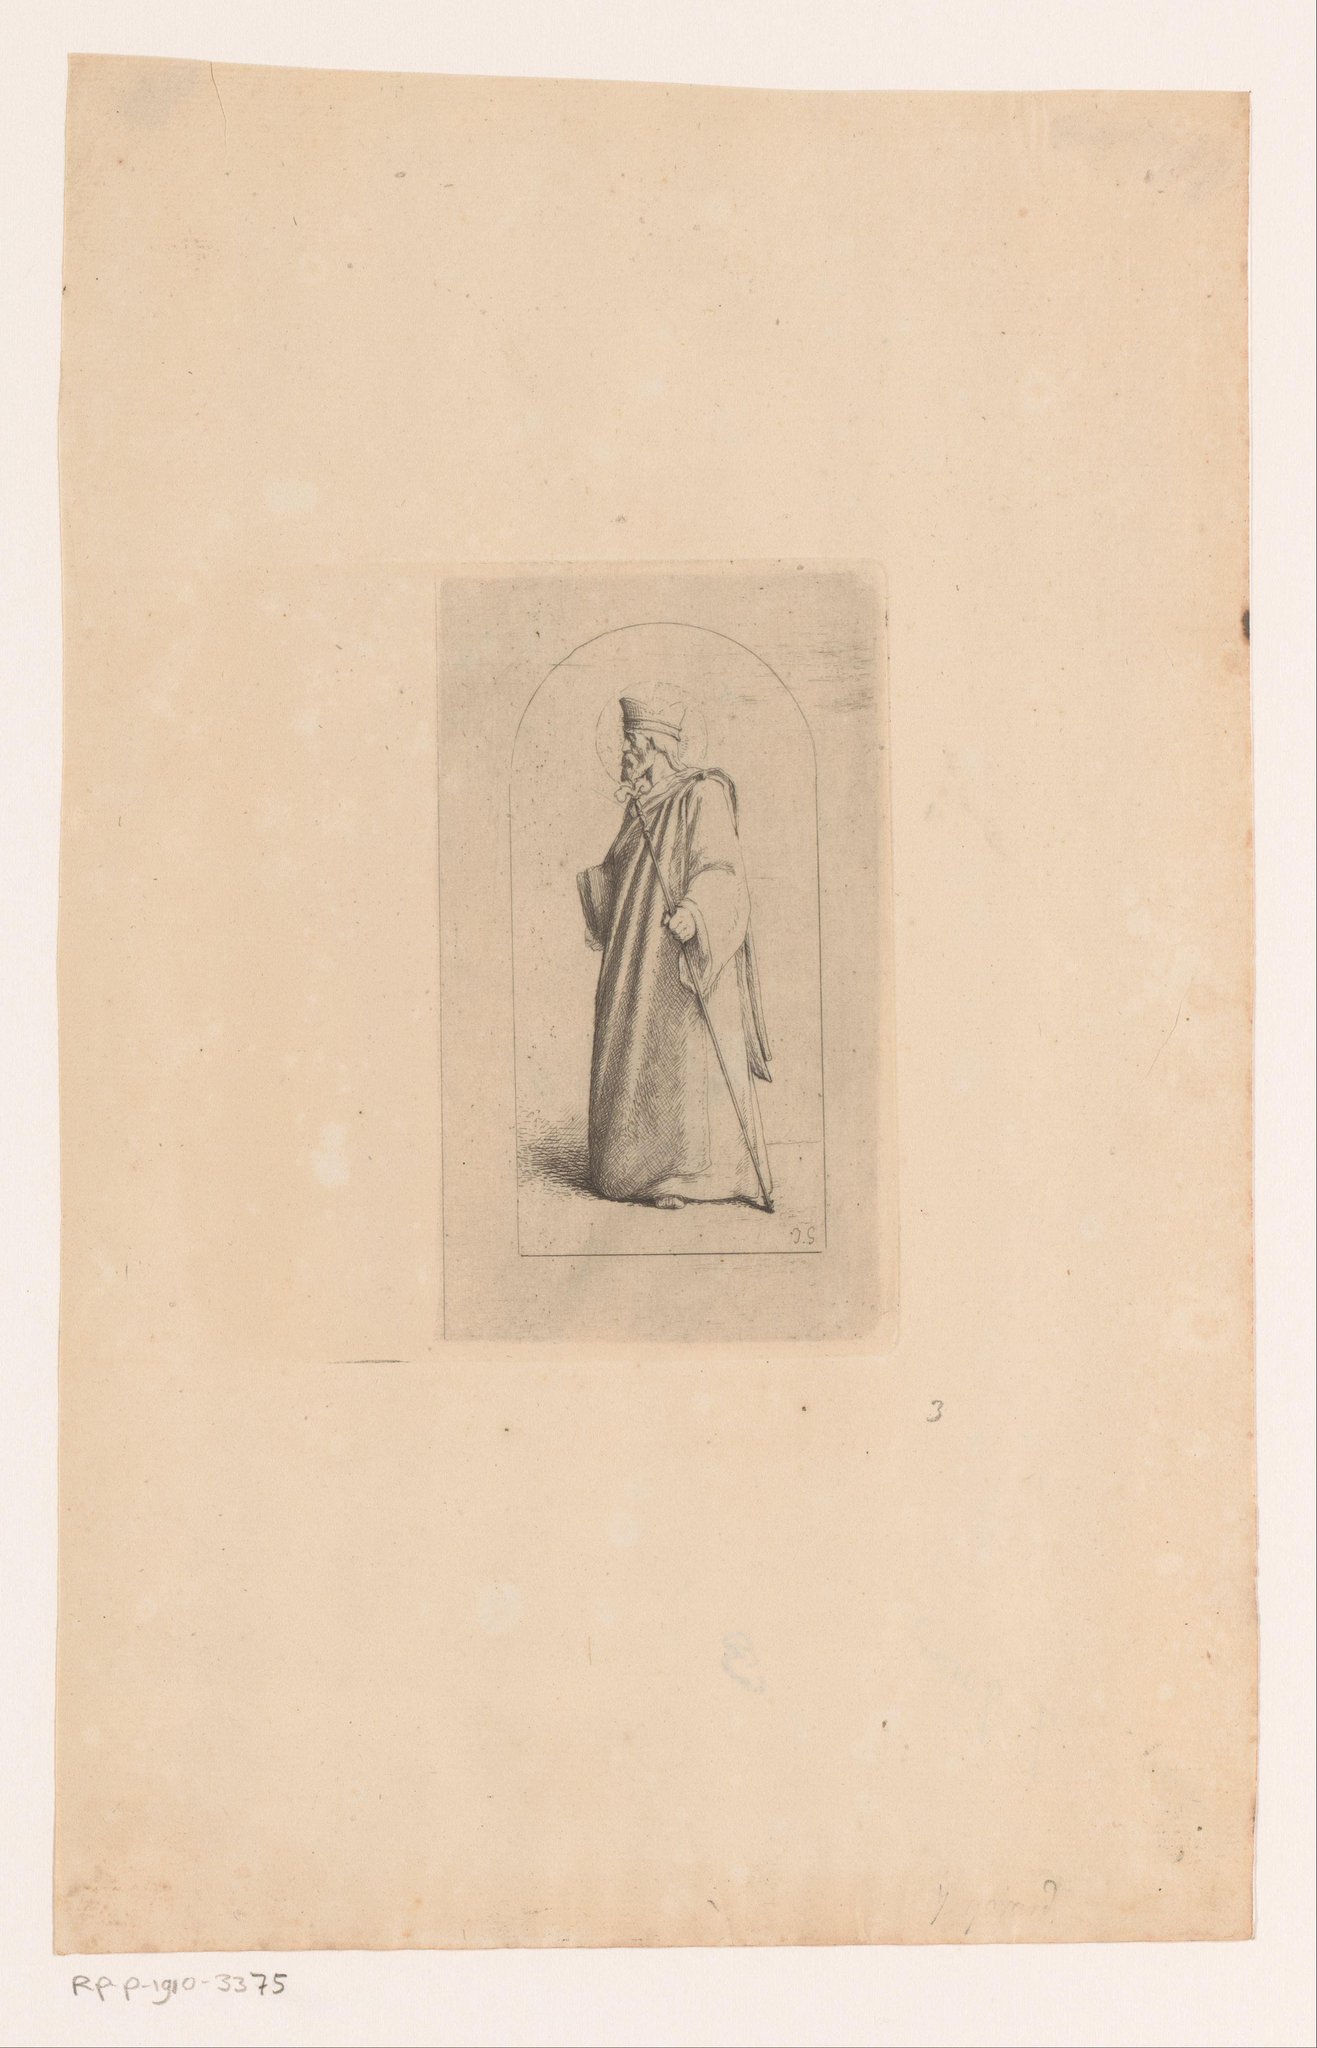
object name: print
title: Bisschop met nimbus en staf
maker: joseph gérard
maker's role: print maker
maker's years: 1821-1895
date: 1831-1895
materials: paper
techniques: etching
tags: archbishop, bishop, etc. (roman catholic)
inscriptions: collector's mark: Lugt 2228